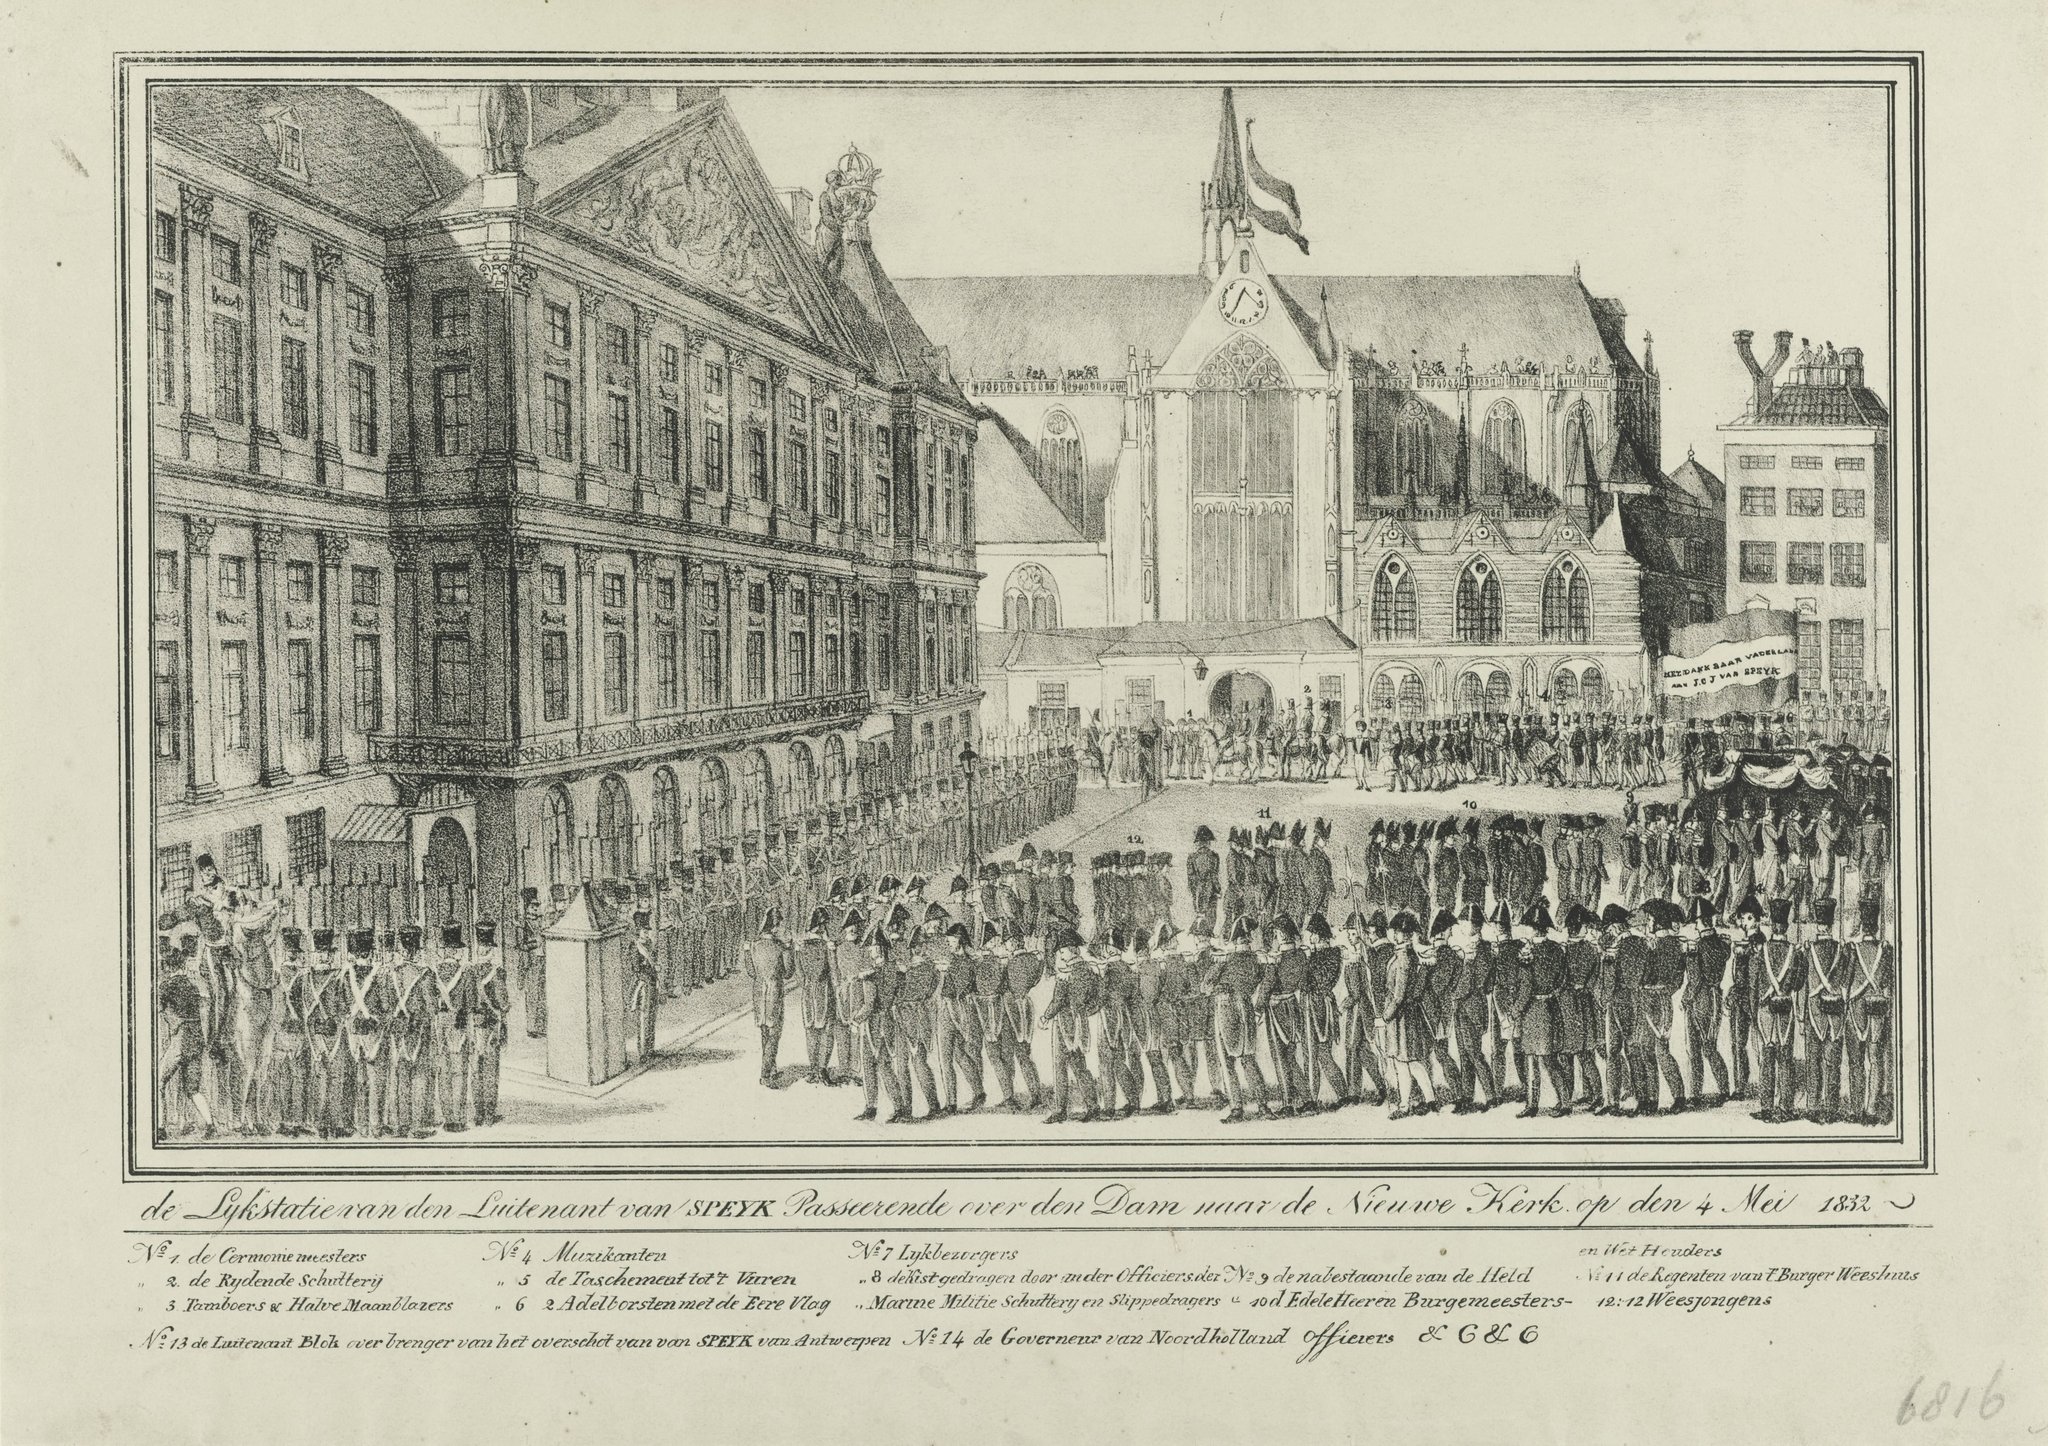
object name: print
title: de Lijkstatie van den Luitenant van Speyk Passeerende over den Dam naar de Nieuwe Kerk op den 4 Mei 1832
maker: Anonymous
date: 1832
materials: paper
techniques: lithograph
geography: netherlands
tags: amsterdam, antwerp, jan van speyk, cortege, funeral procession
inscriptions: collector's mark: Lugt 2228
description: De begrafenisstoet van Jan van Speyk komt aan bij de Dam en de Nieuwe Kerk te Amsterdam, 4 mei 1832. In het onderschrift de legenda 1-12.